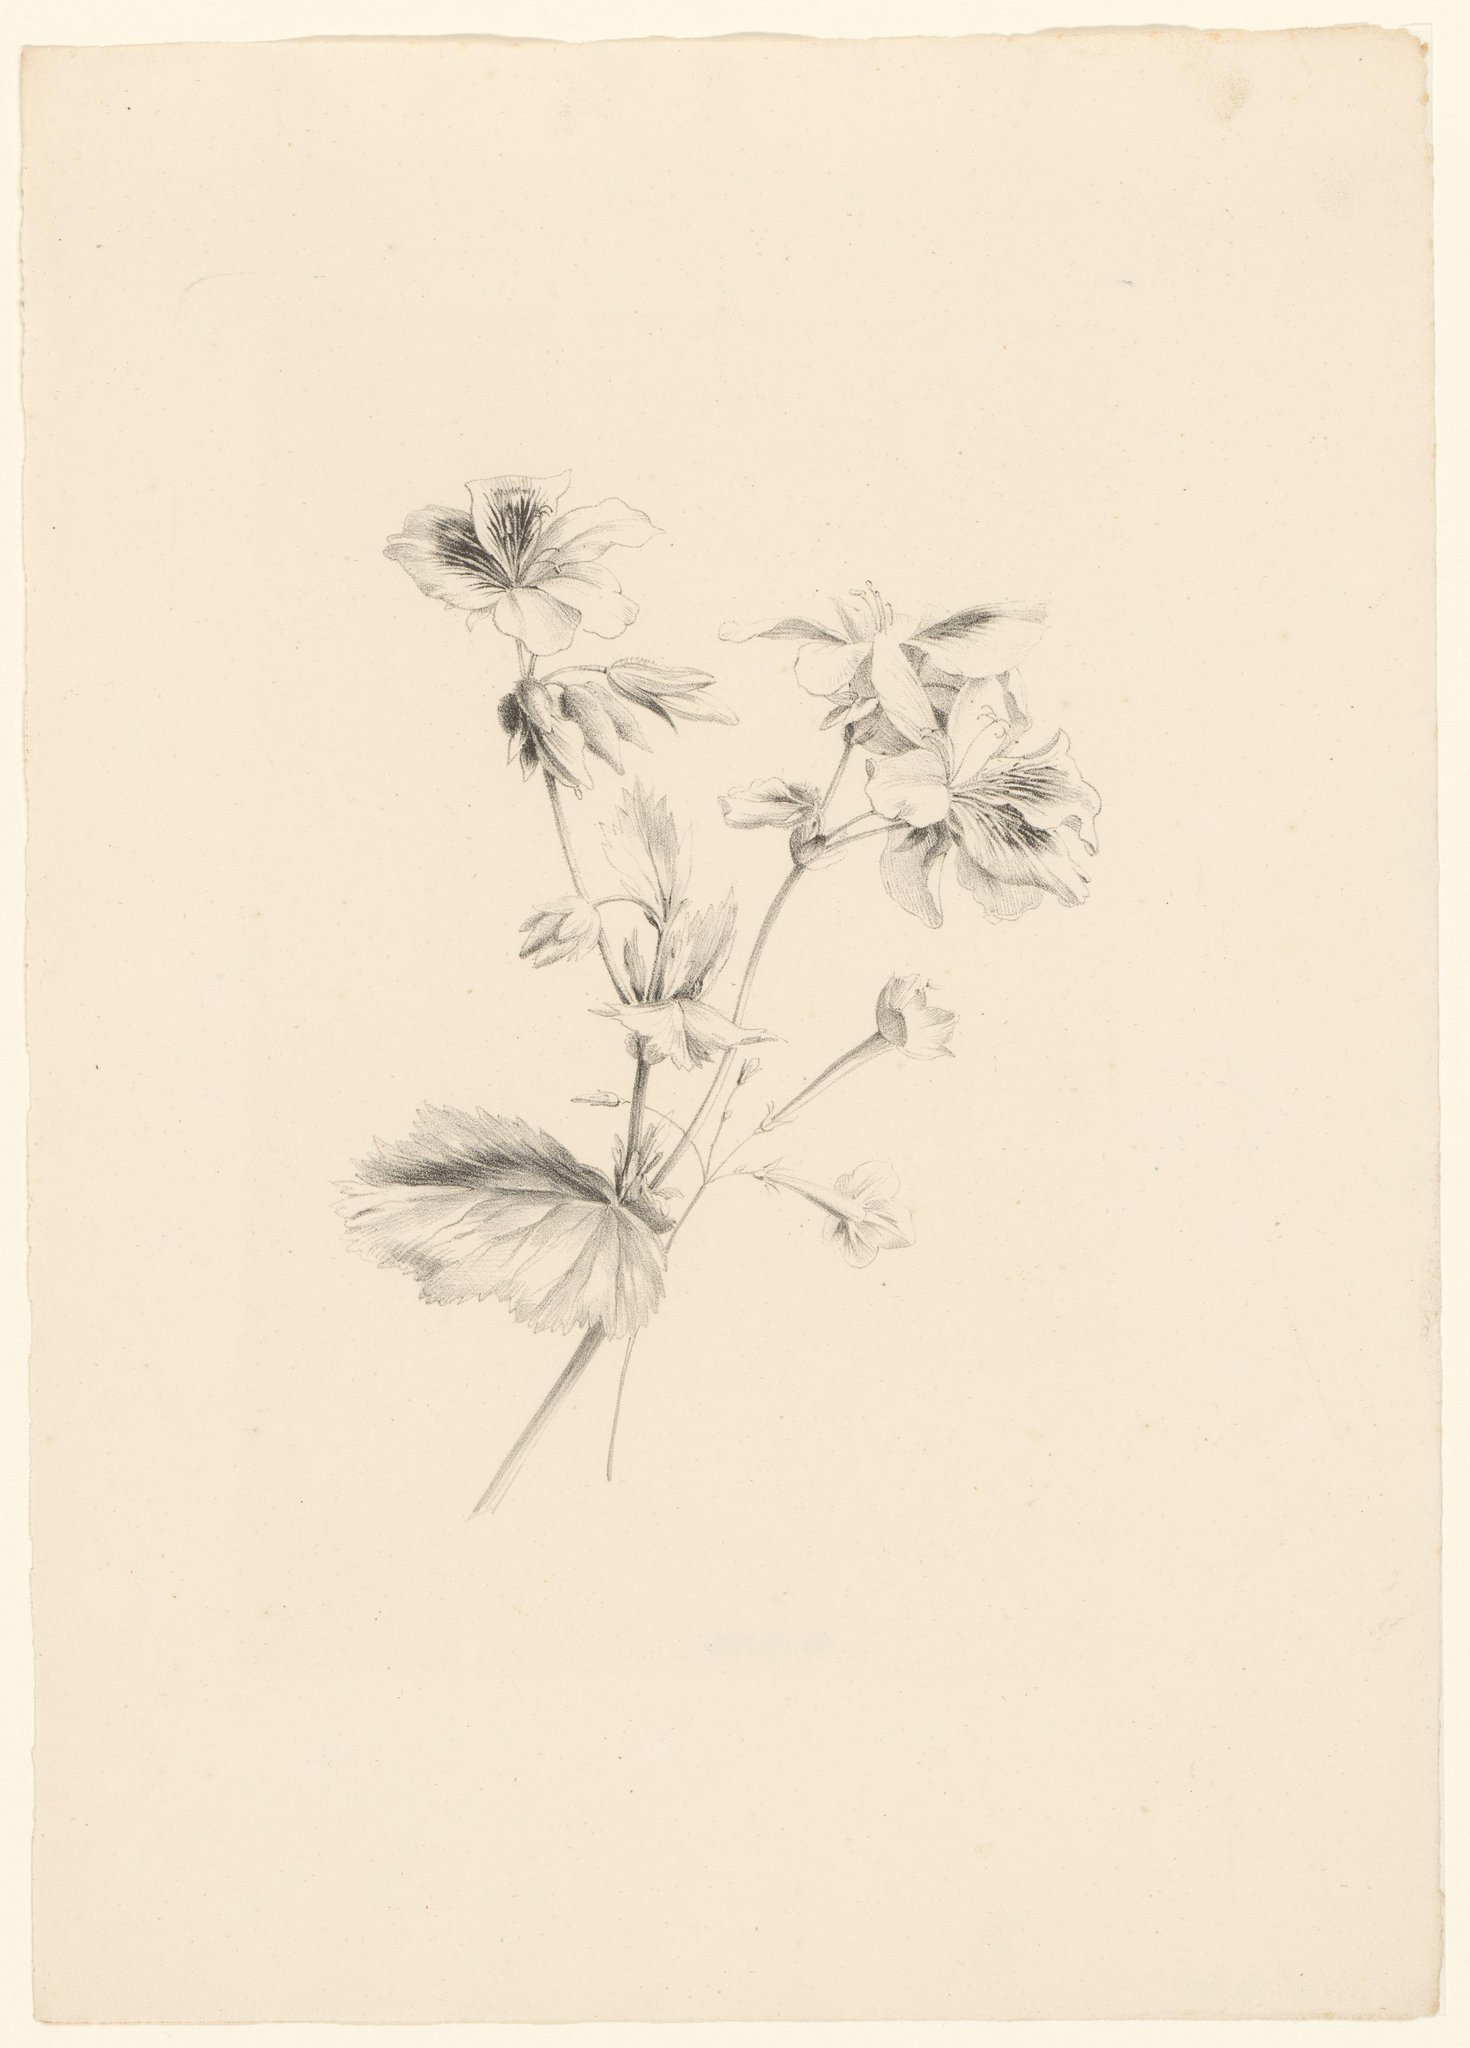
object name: print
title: Bloemen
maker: anton weiss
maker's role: draughtsman, print maker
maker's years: 1801-1851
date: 1831-1832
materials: paper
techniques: lithograph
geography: amsterdam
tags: flowers